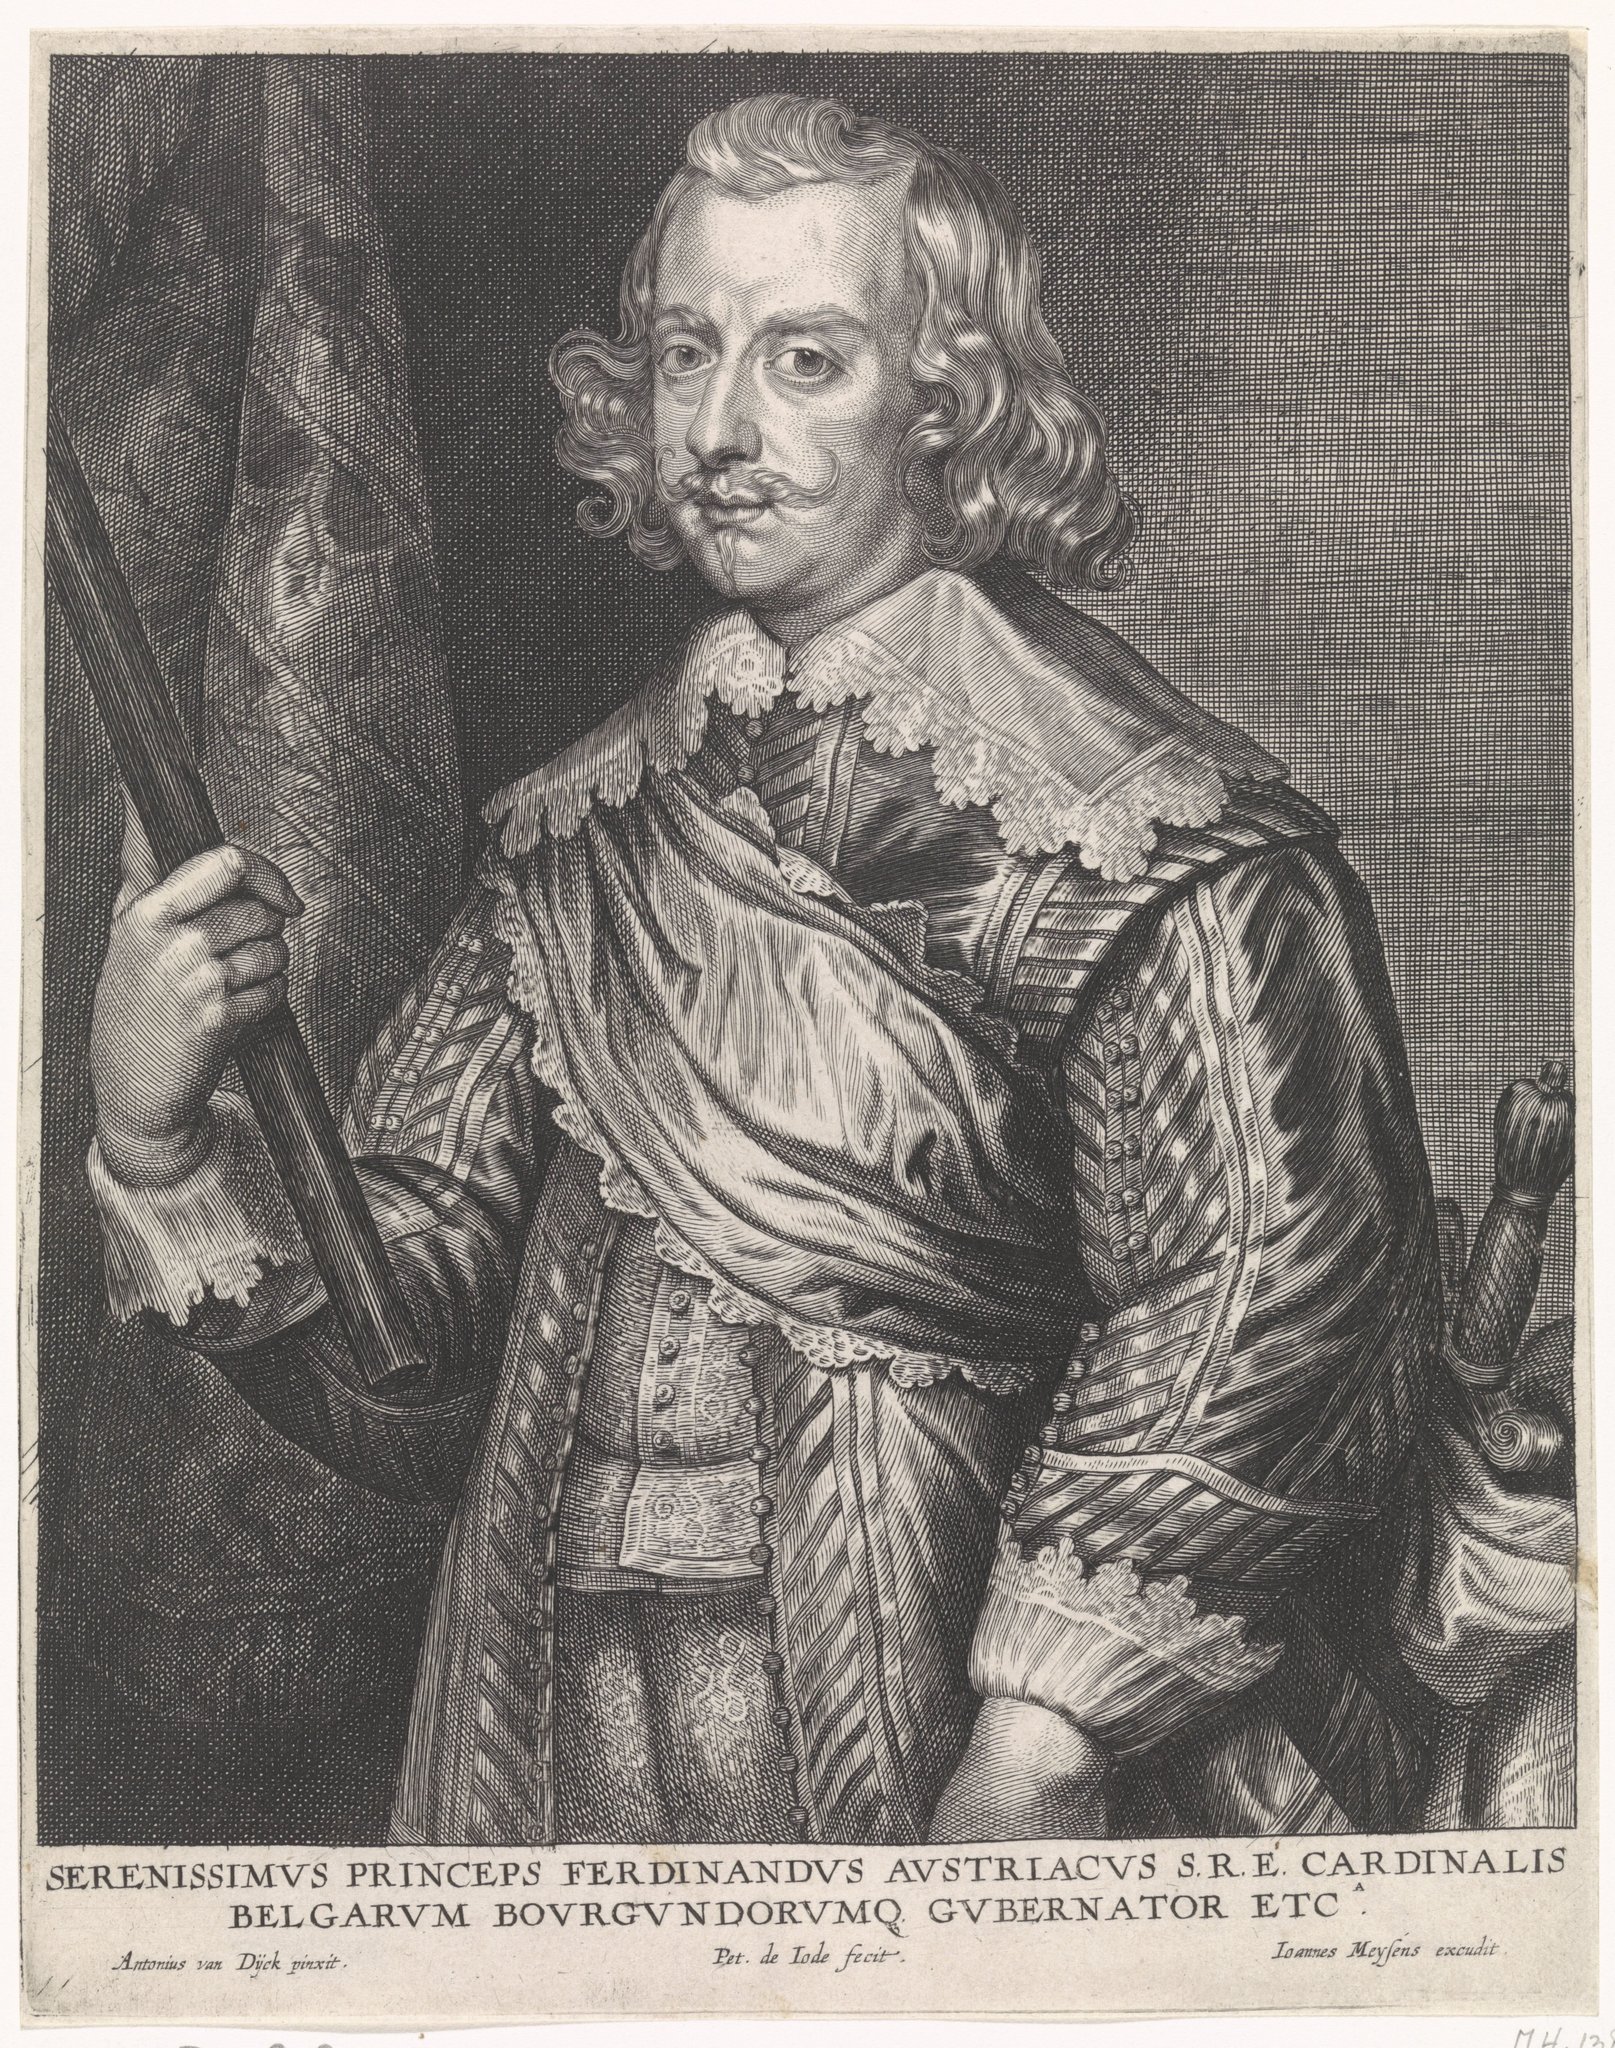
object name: print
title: Portret van Ferdinand van Oostenrijk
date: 1628-1670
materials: paper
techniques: engraving, etching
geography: antwerp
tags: brussels, landvoogd der zuidelijke nederlanden ferdinand van oostenrijk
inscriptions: collector's mark: Lugt 240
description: Portret van Ferdinand van Oostenrijk, ten halven lijve. In zijn rechterhand houdt hij een commandostaf. In de marge een tweeregelig onderschrift in het Latijn.